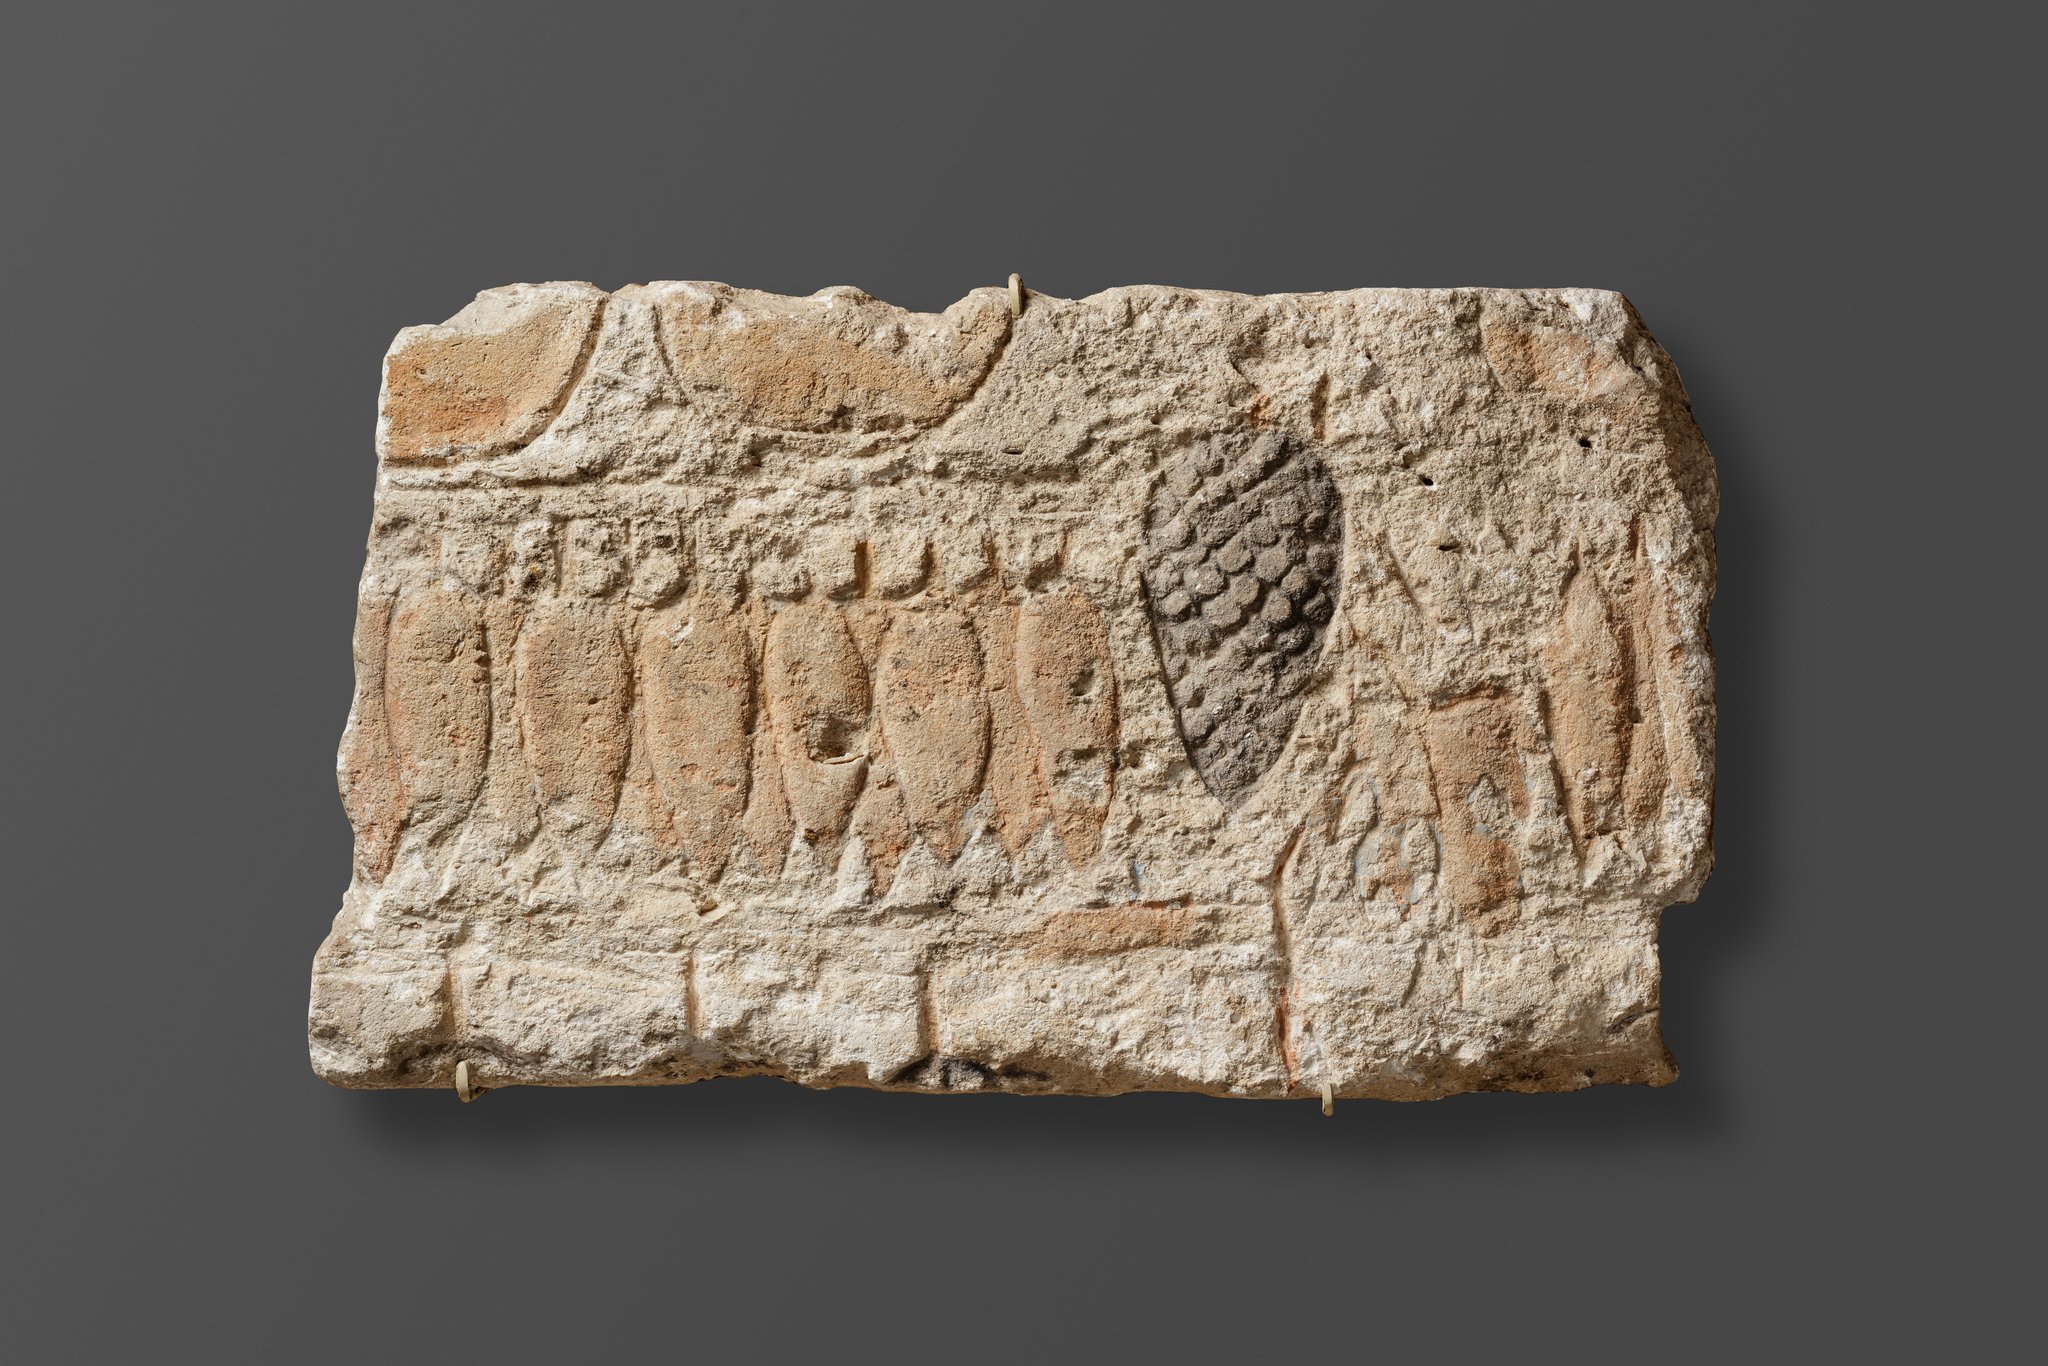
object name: talatat, flower, fruit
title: Relief with floral and fructal wall decoration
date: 1353-1336 BCE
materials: limestone, paint